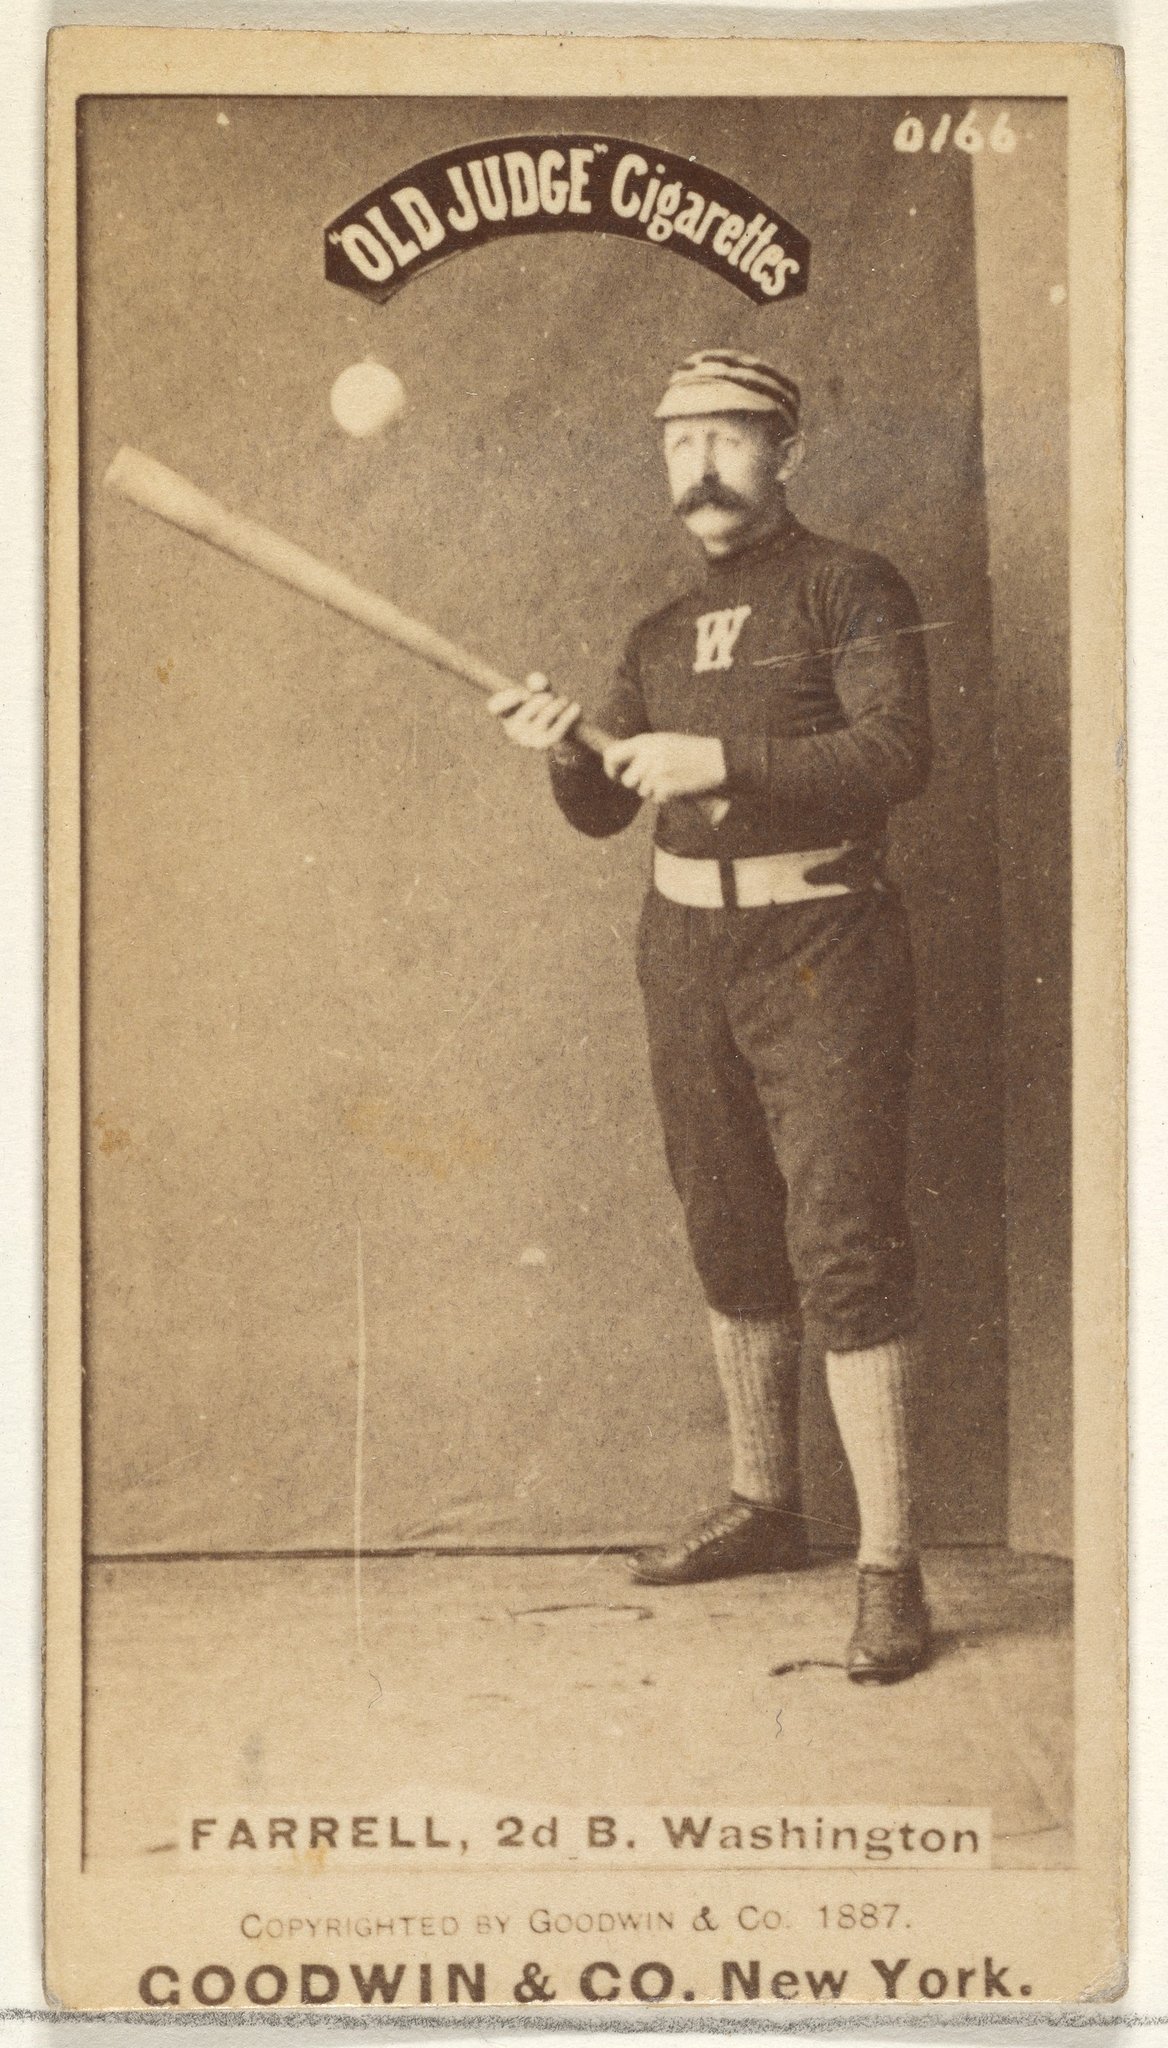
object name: baseball card, photograph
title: John A. "Jack" Farrell, 2nd Base, Washington Nationals, from the Old Judge series (N172) for Old Judge Cigarettes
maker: goodwin & company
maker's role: publisher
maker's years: 1850-1950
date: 1887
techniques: albumen silver print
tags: men,portraits,baseball,athletes